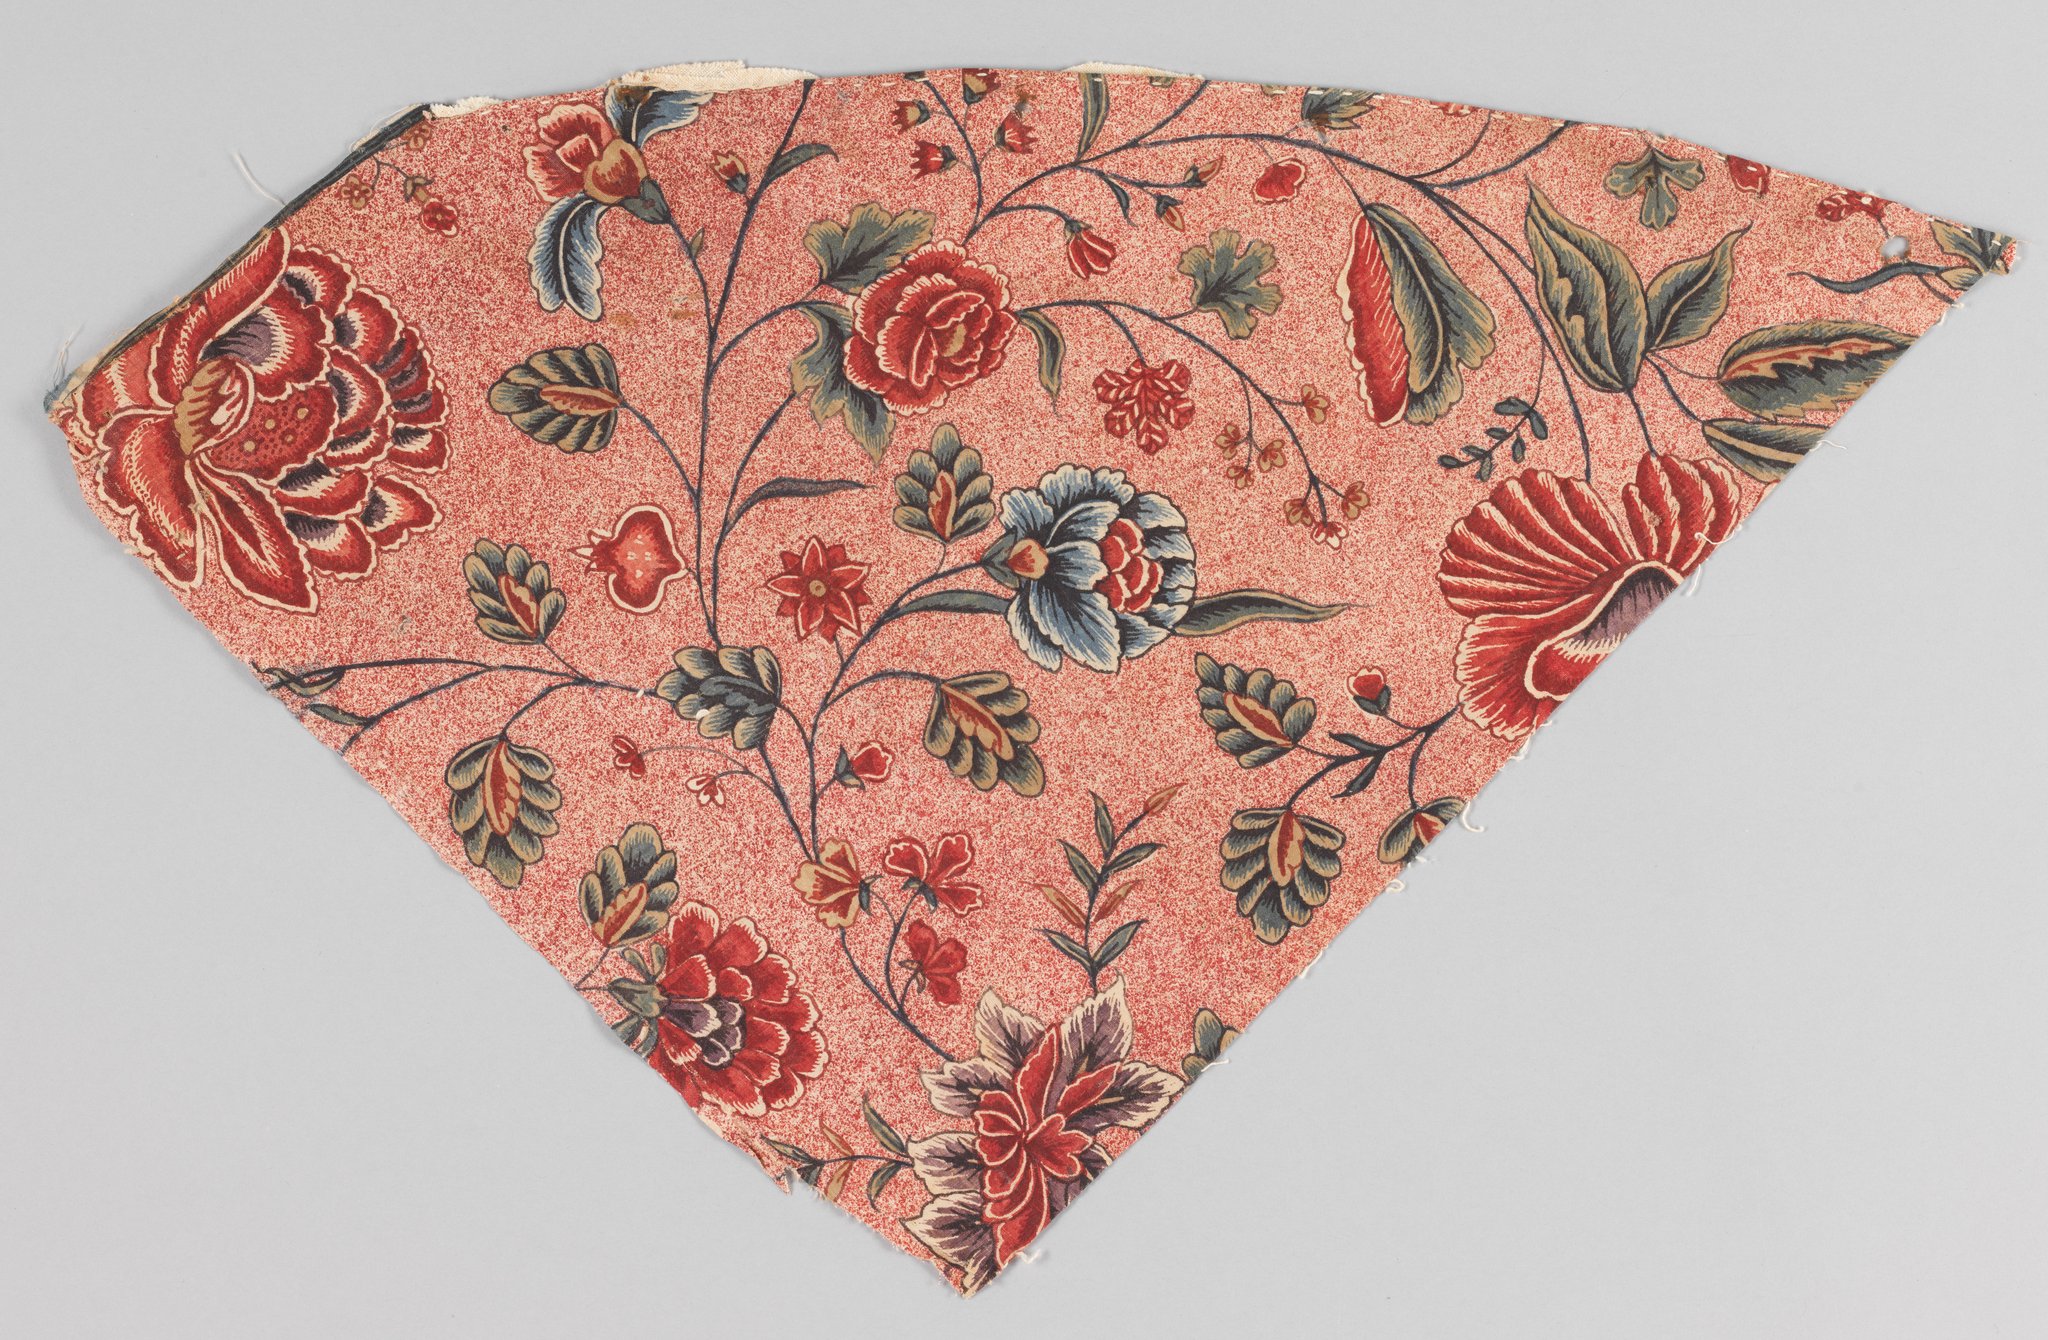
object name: fragment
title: Fragment of Indian chintz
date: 1701-1800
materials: cotton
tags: flowers